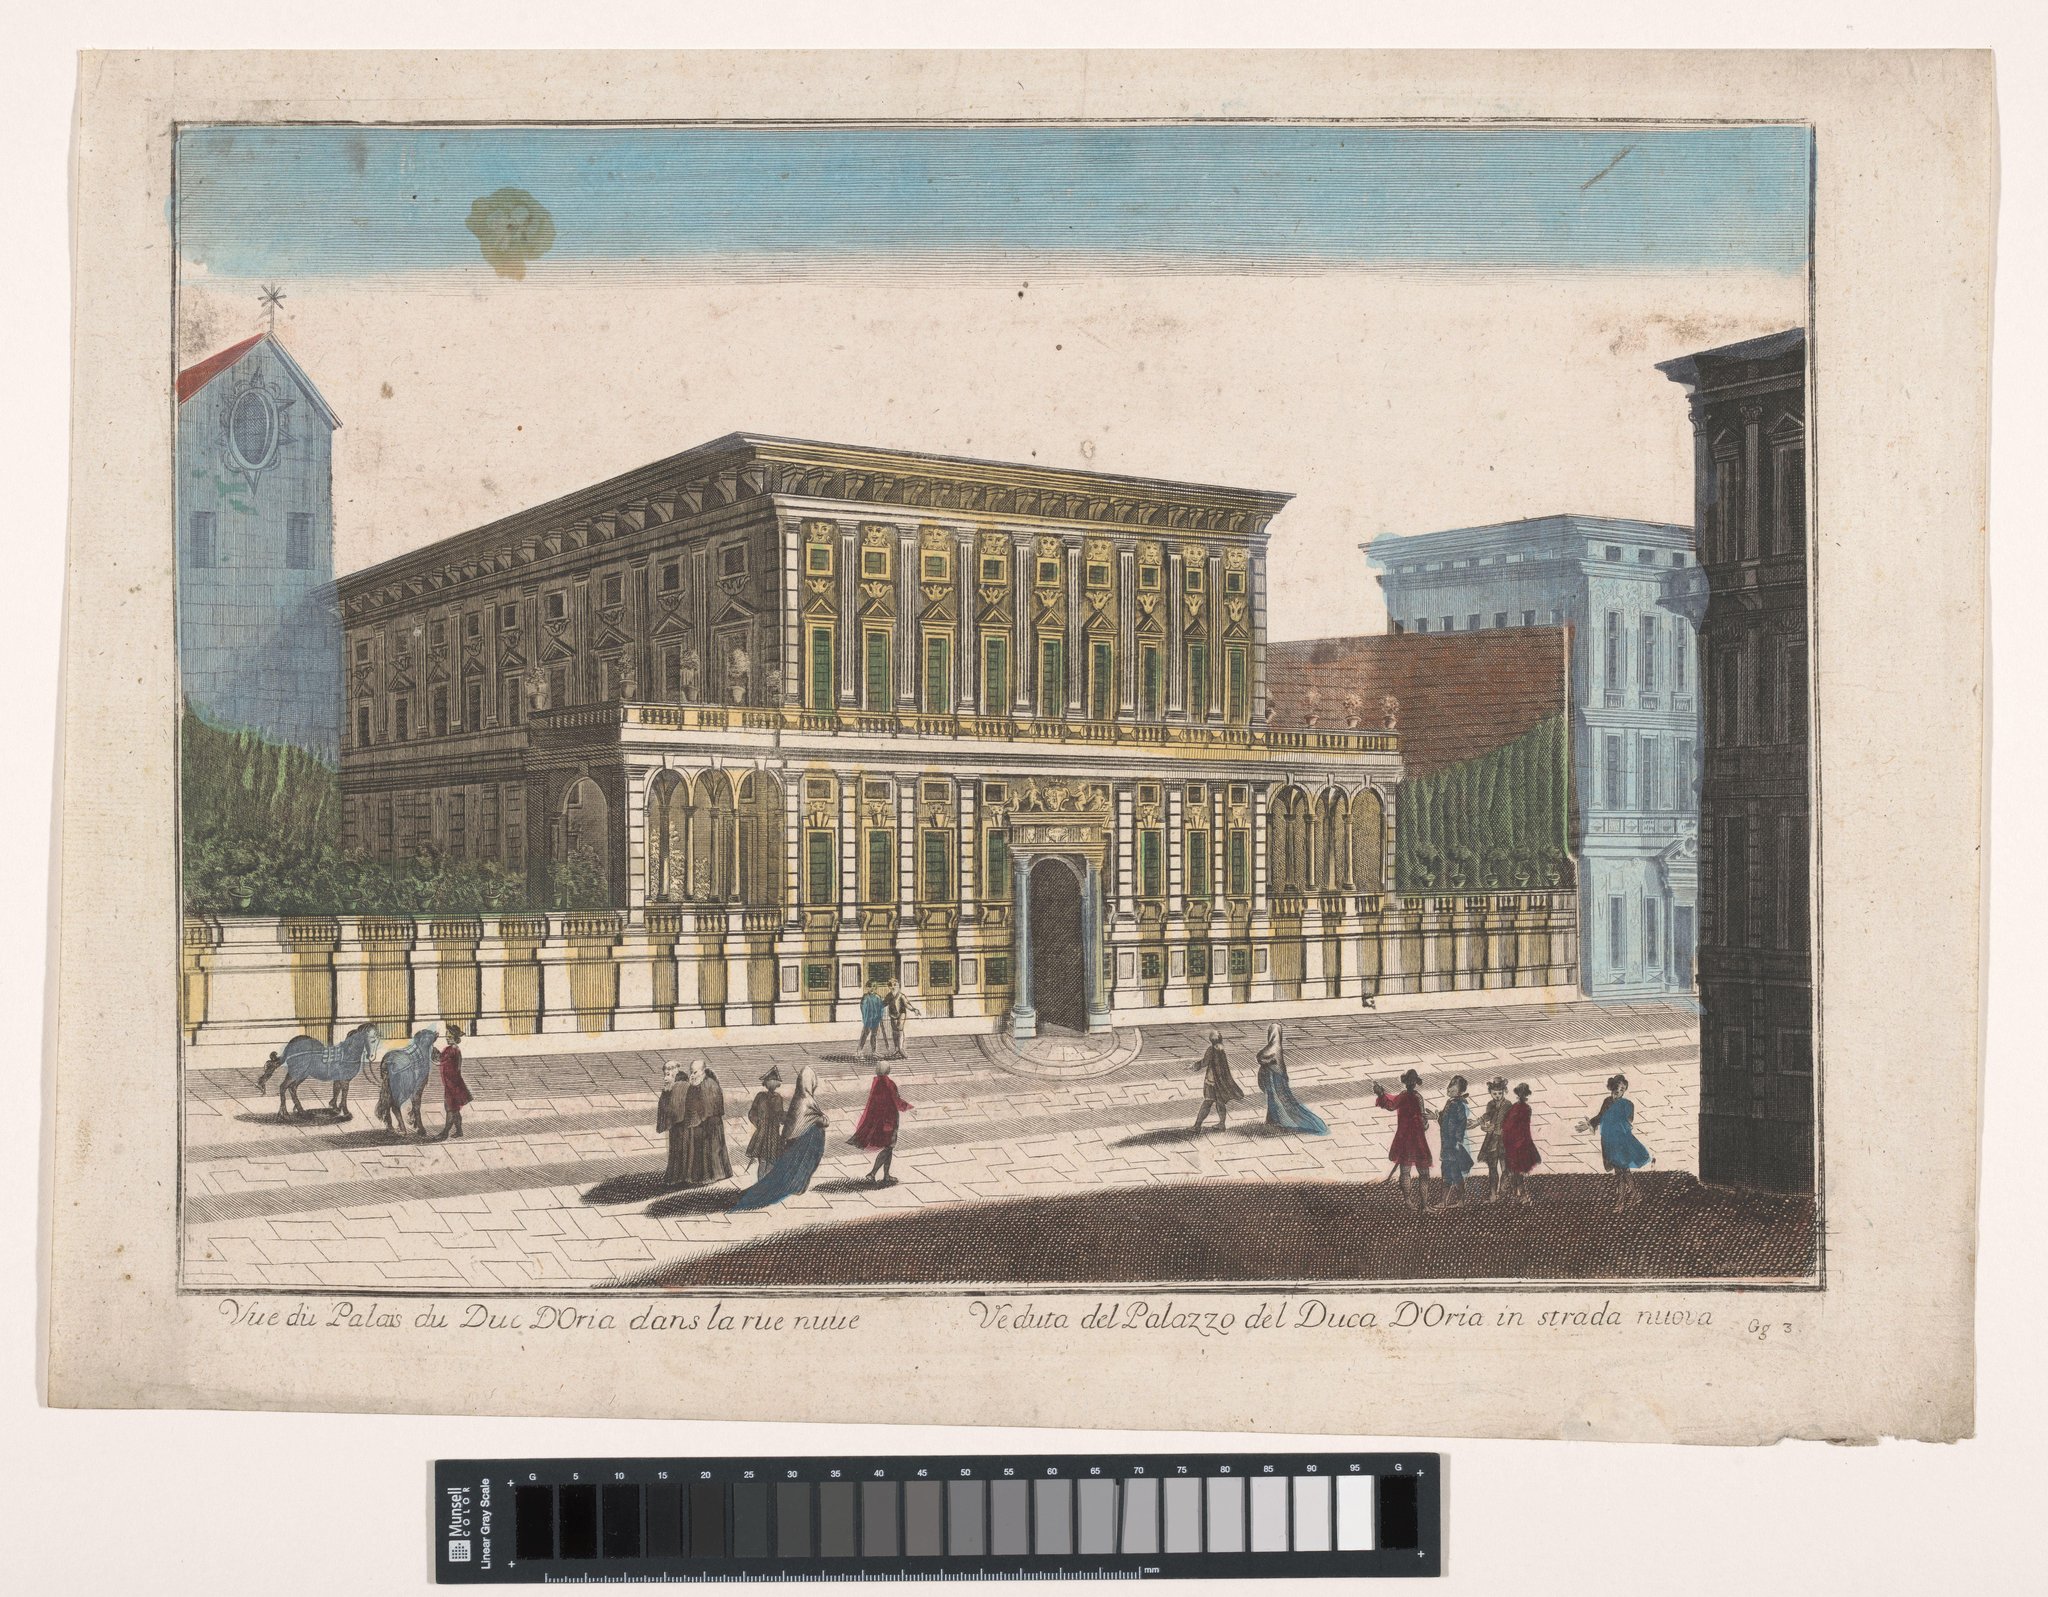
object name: print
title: Gezicht op het Palazzo Doria-Tursi te Genua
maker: Anonymous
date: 1700-1799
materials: paper, watercolor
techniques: brush, etching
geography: italy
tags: palace, street (+ city(-scape) with figures, staffage)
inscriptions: collector's mark: Lugt 2228